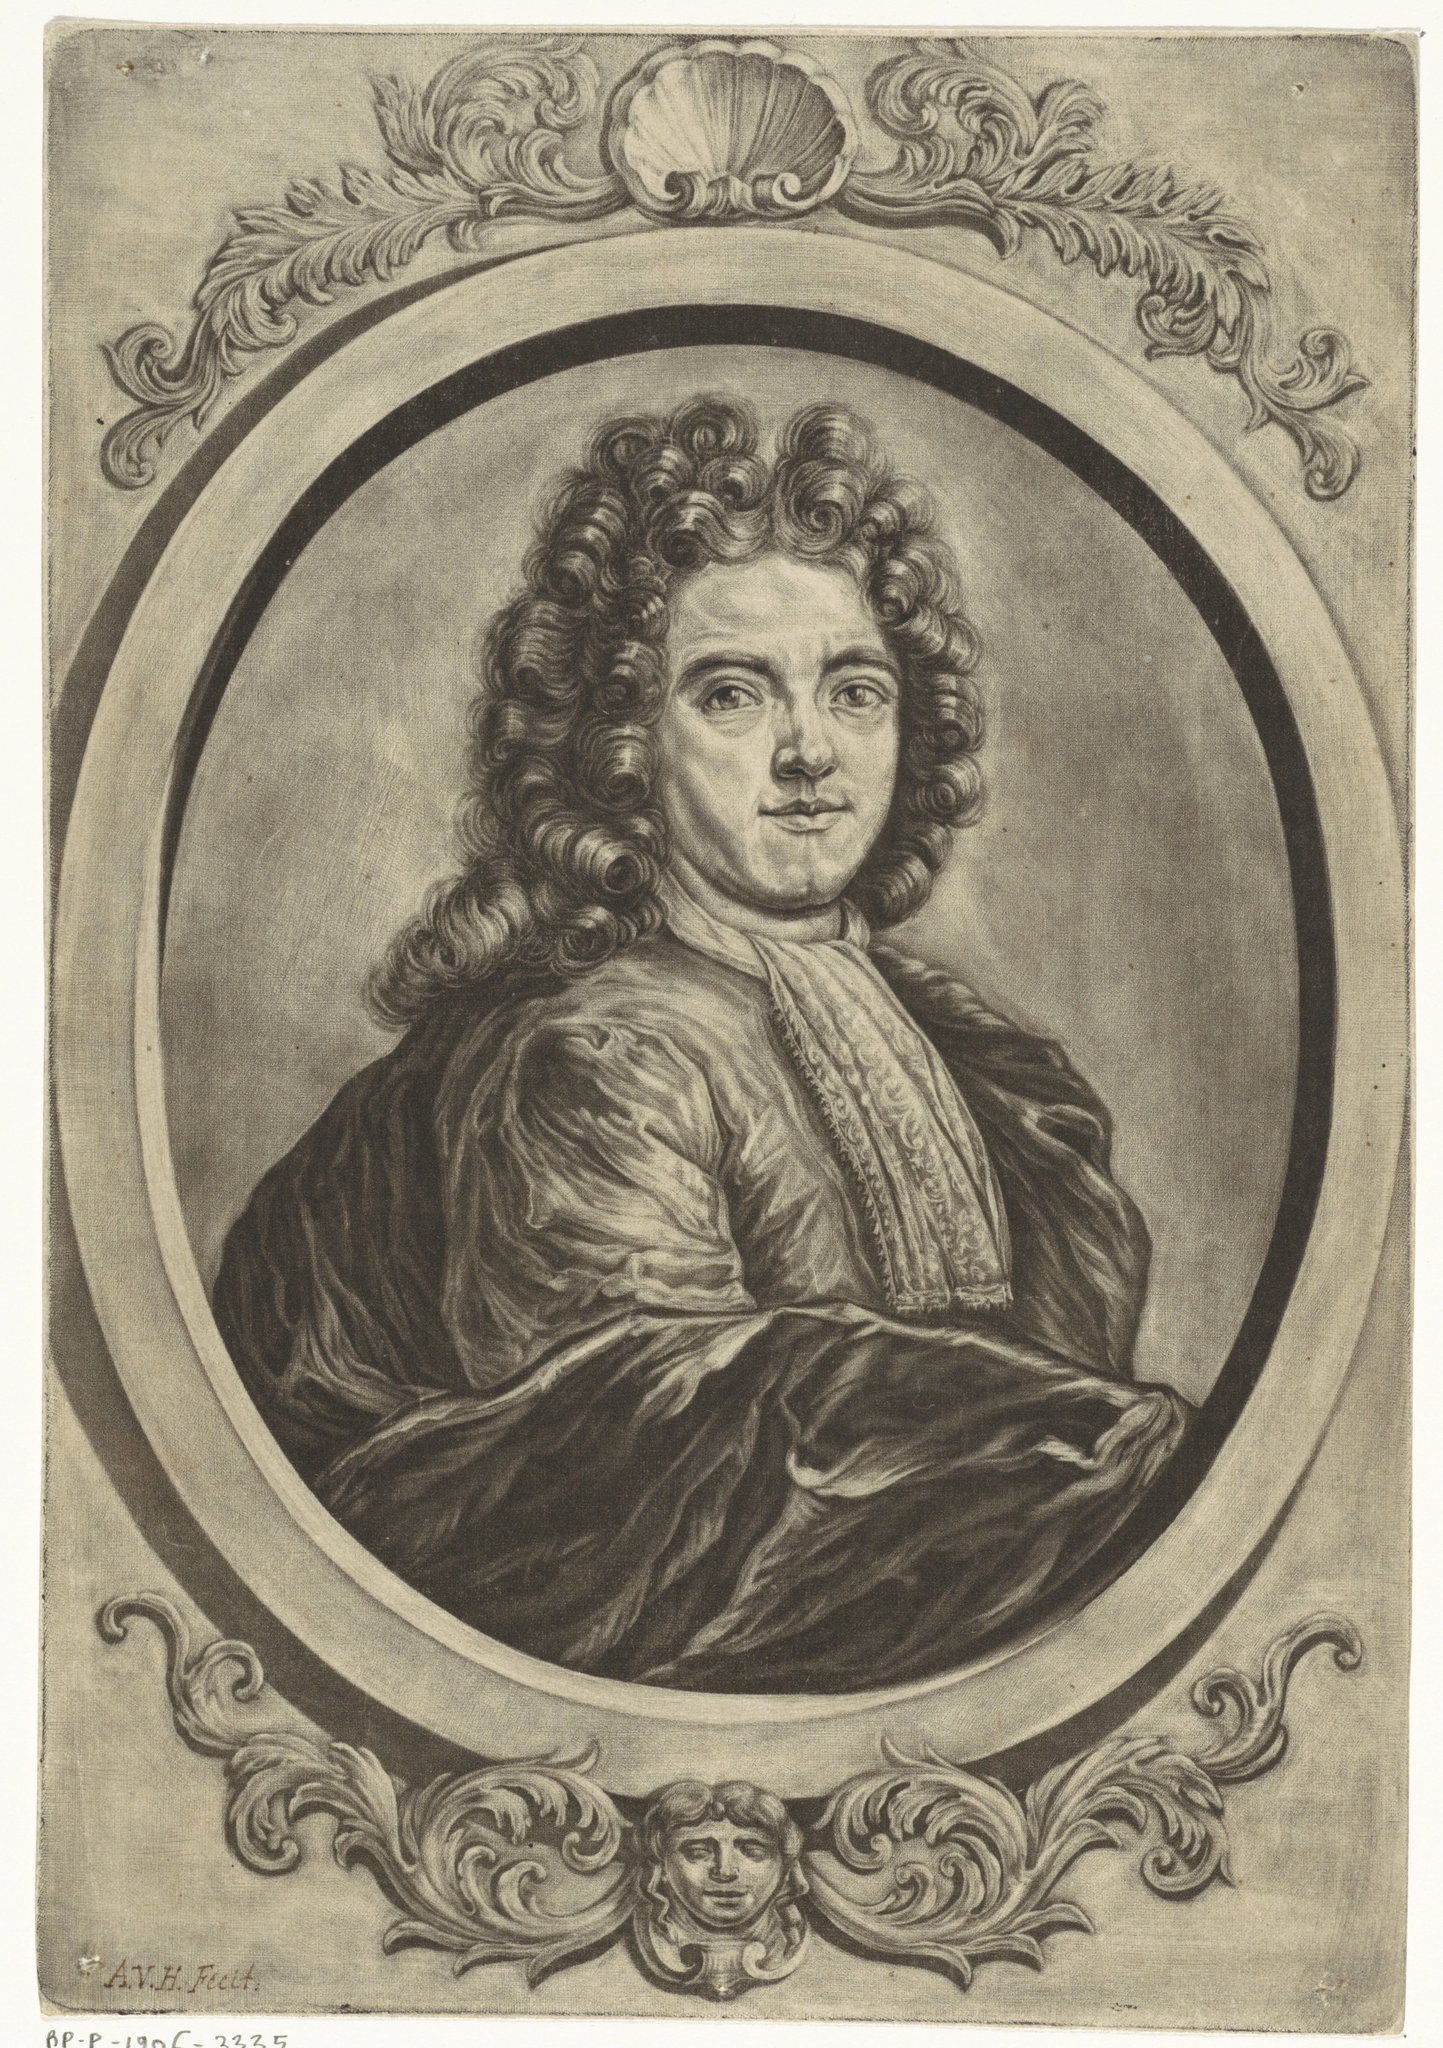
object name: print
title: Zelfportret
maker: arnoud van halen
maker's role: draughtsman, painter, print maker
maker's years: 1673-1732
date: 1683-1732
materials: paper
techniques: pen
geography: amsterdam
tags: amsterdam, painter, print maker, draughtsman, arnoud van halen, portrait, self-portrait of artist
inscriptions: collector's mark: Lugt 2228, inscription: ‘A.V.H. Fecit.’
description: De schilder en tekenaar Arnoud van Halen gevat in een ovaal met onder en boven versierselen.